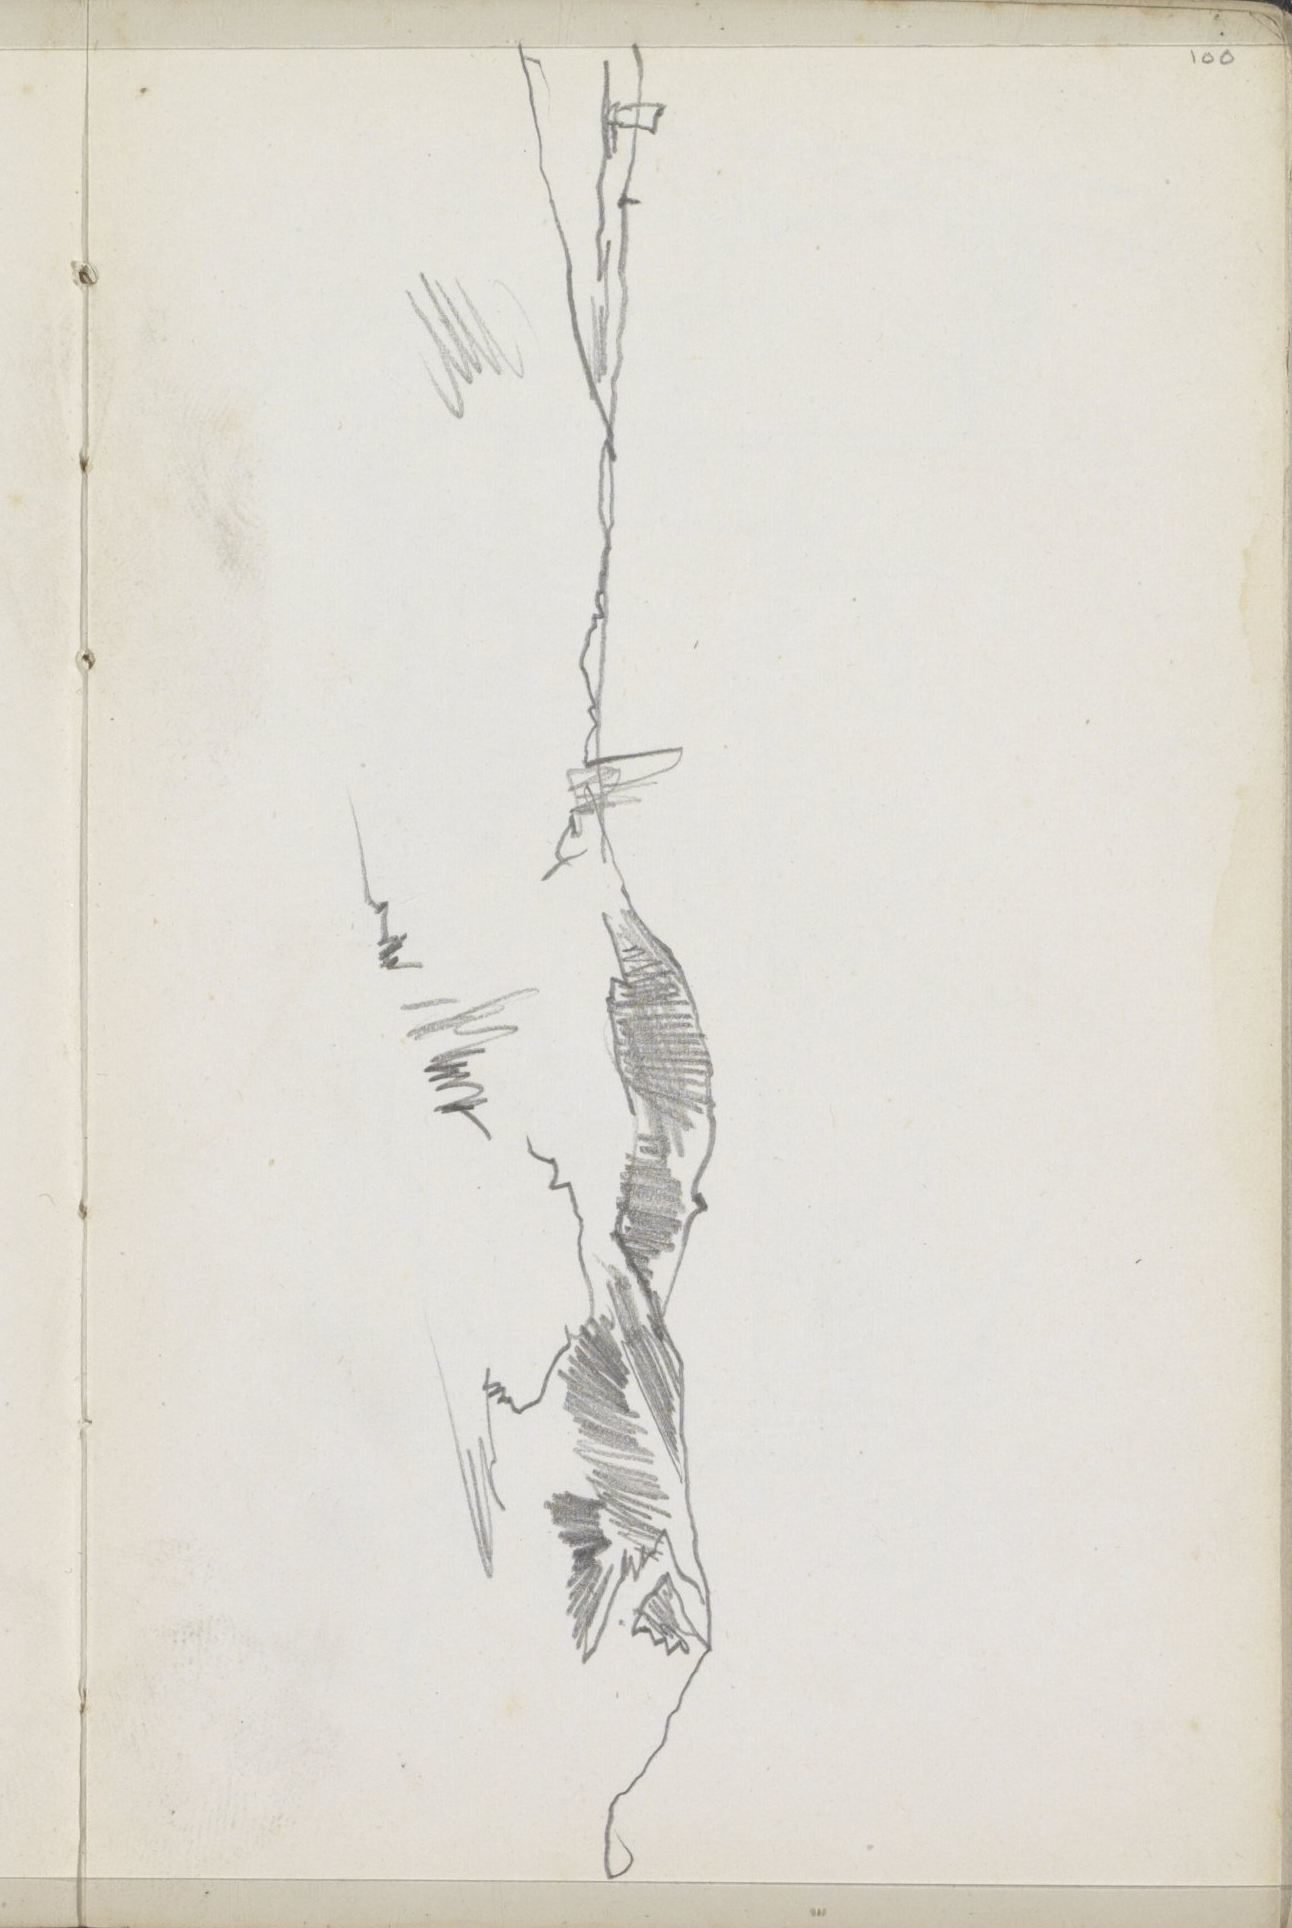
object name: sketchbook leaf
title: Landschap, mogelijk een duinlandschap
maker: george hendrik breitner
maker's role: draughtsman, painter, print maker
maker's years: 1857-1923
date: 1880-1882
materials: paper, pencil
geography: south holland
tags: dune coast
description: Pagina 100 uit een schetsboek met 72 bladen.